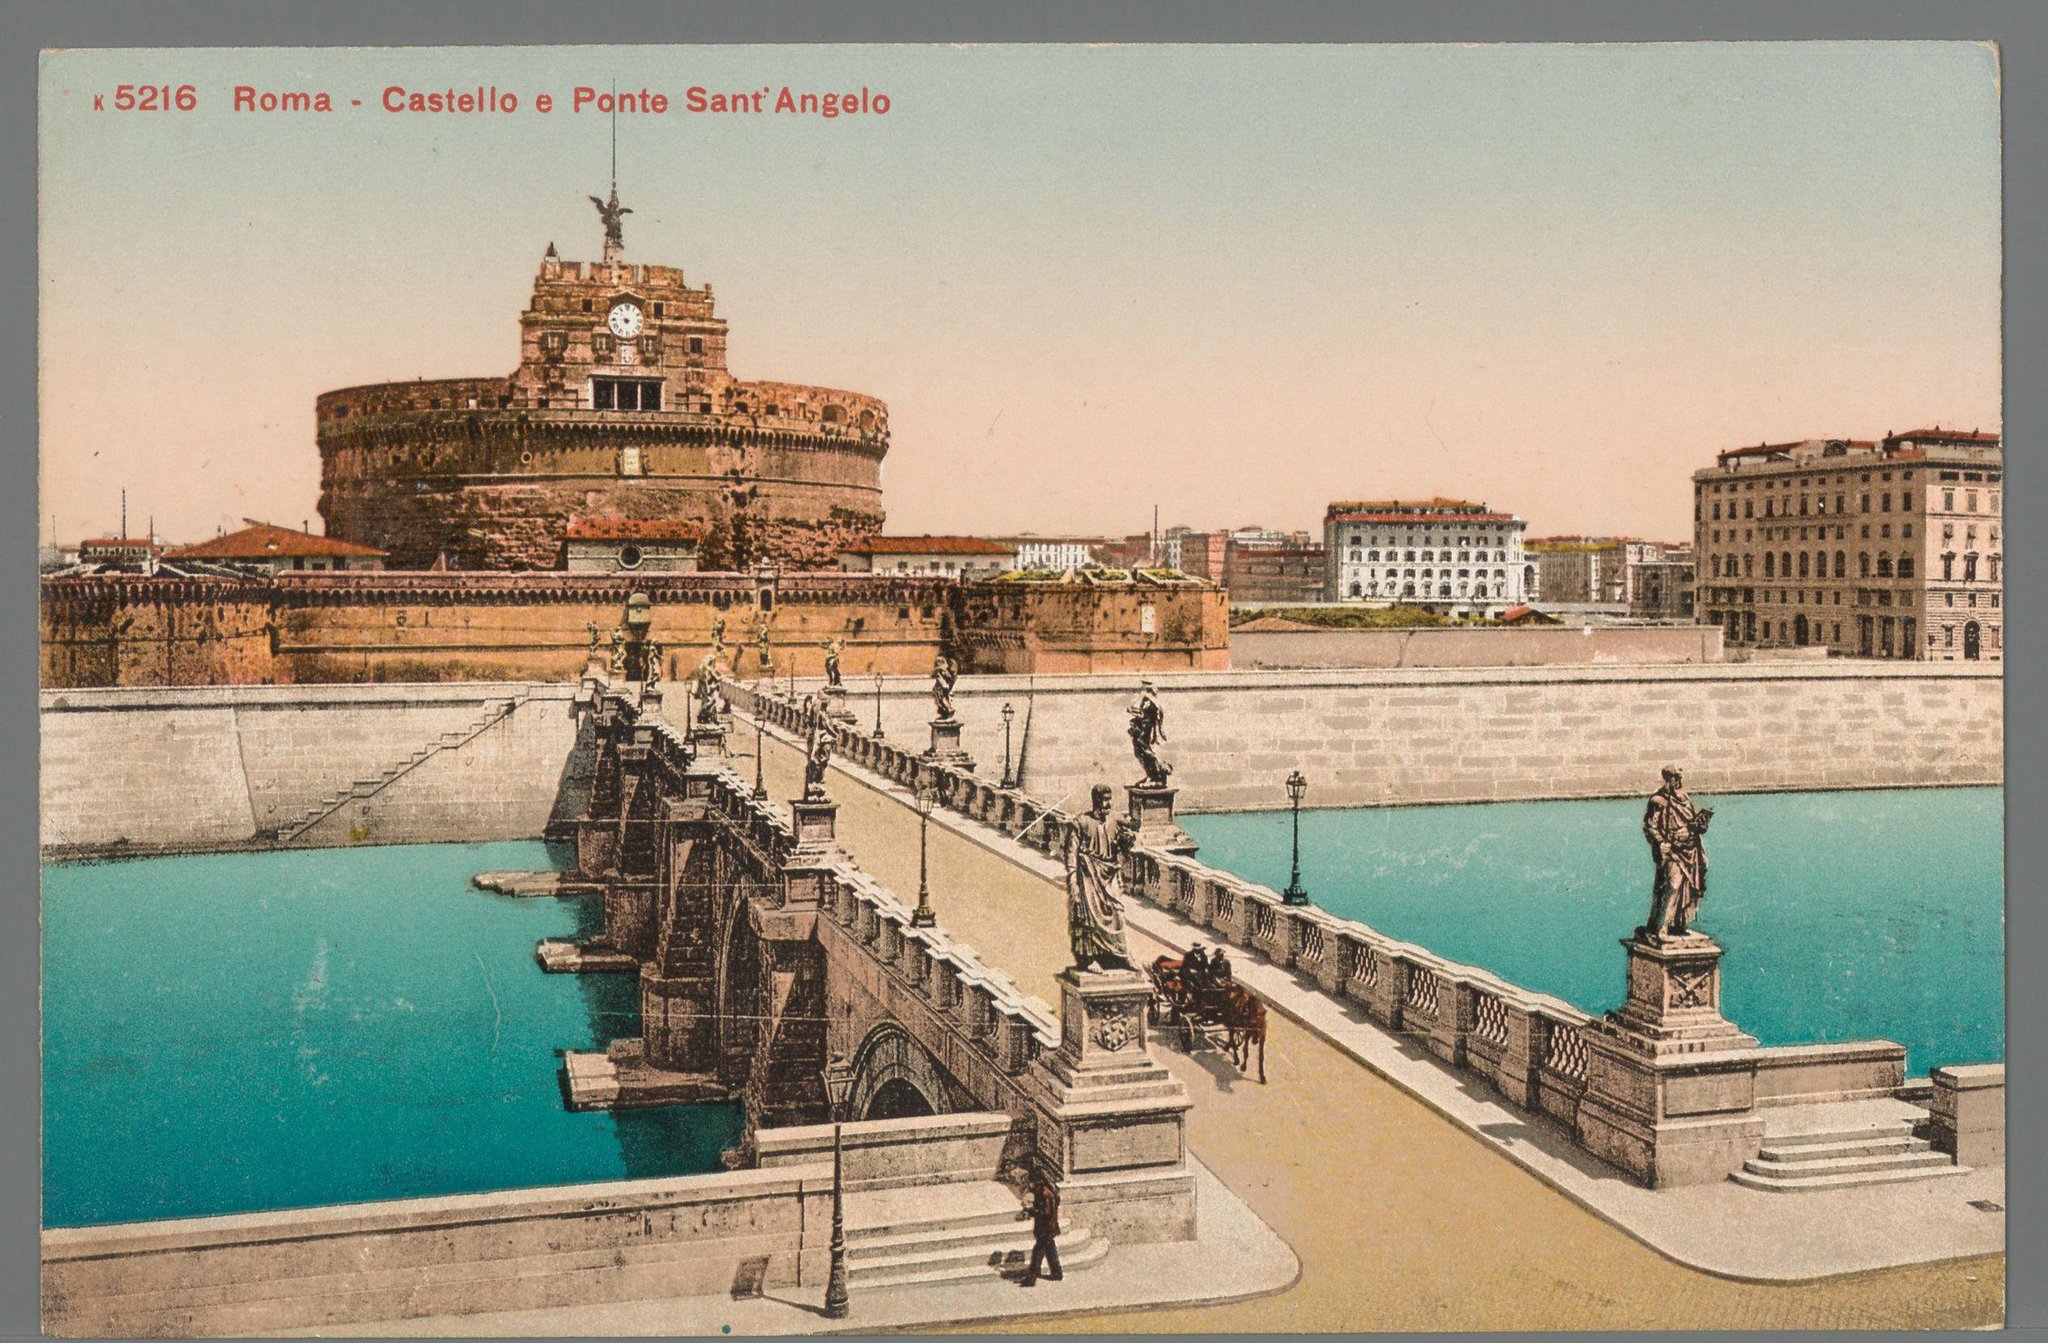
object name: ansichtkaart, prentbriefkaart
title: Roma. Castello e Ponte Sant'Angelo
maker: Anonymous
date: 1905-1930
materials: cardboard, photographic process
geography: zurich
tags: fortress, bridge, city-view, and landscape with man-made constructions (+ city(-scape) with figures, staffage)